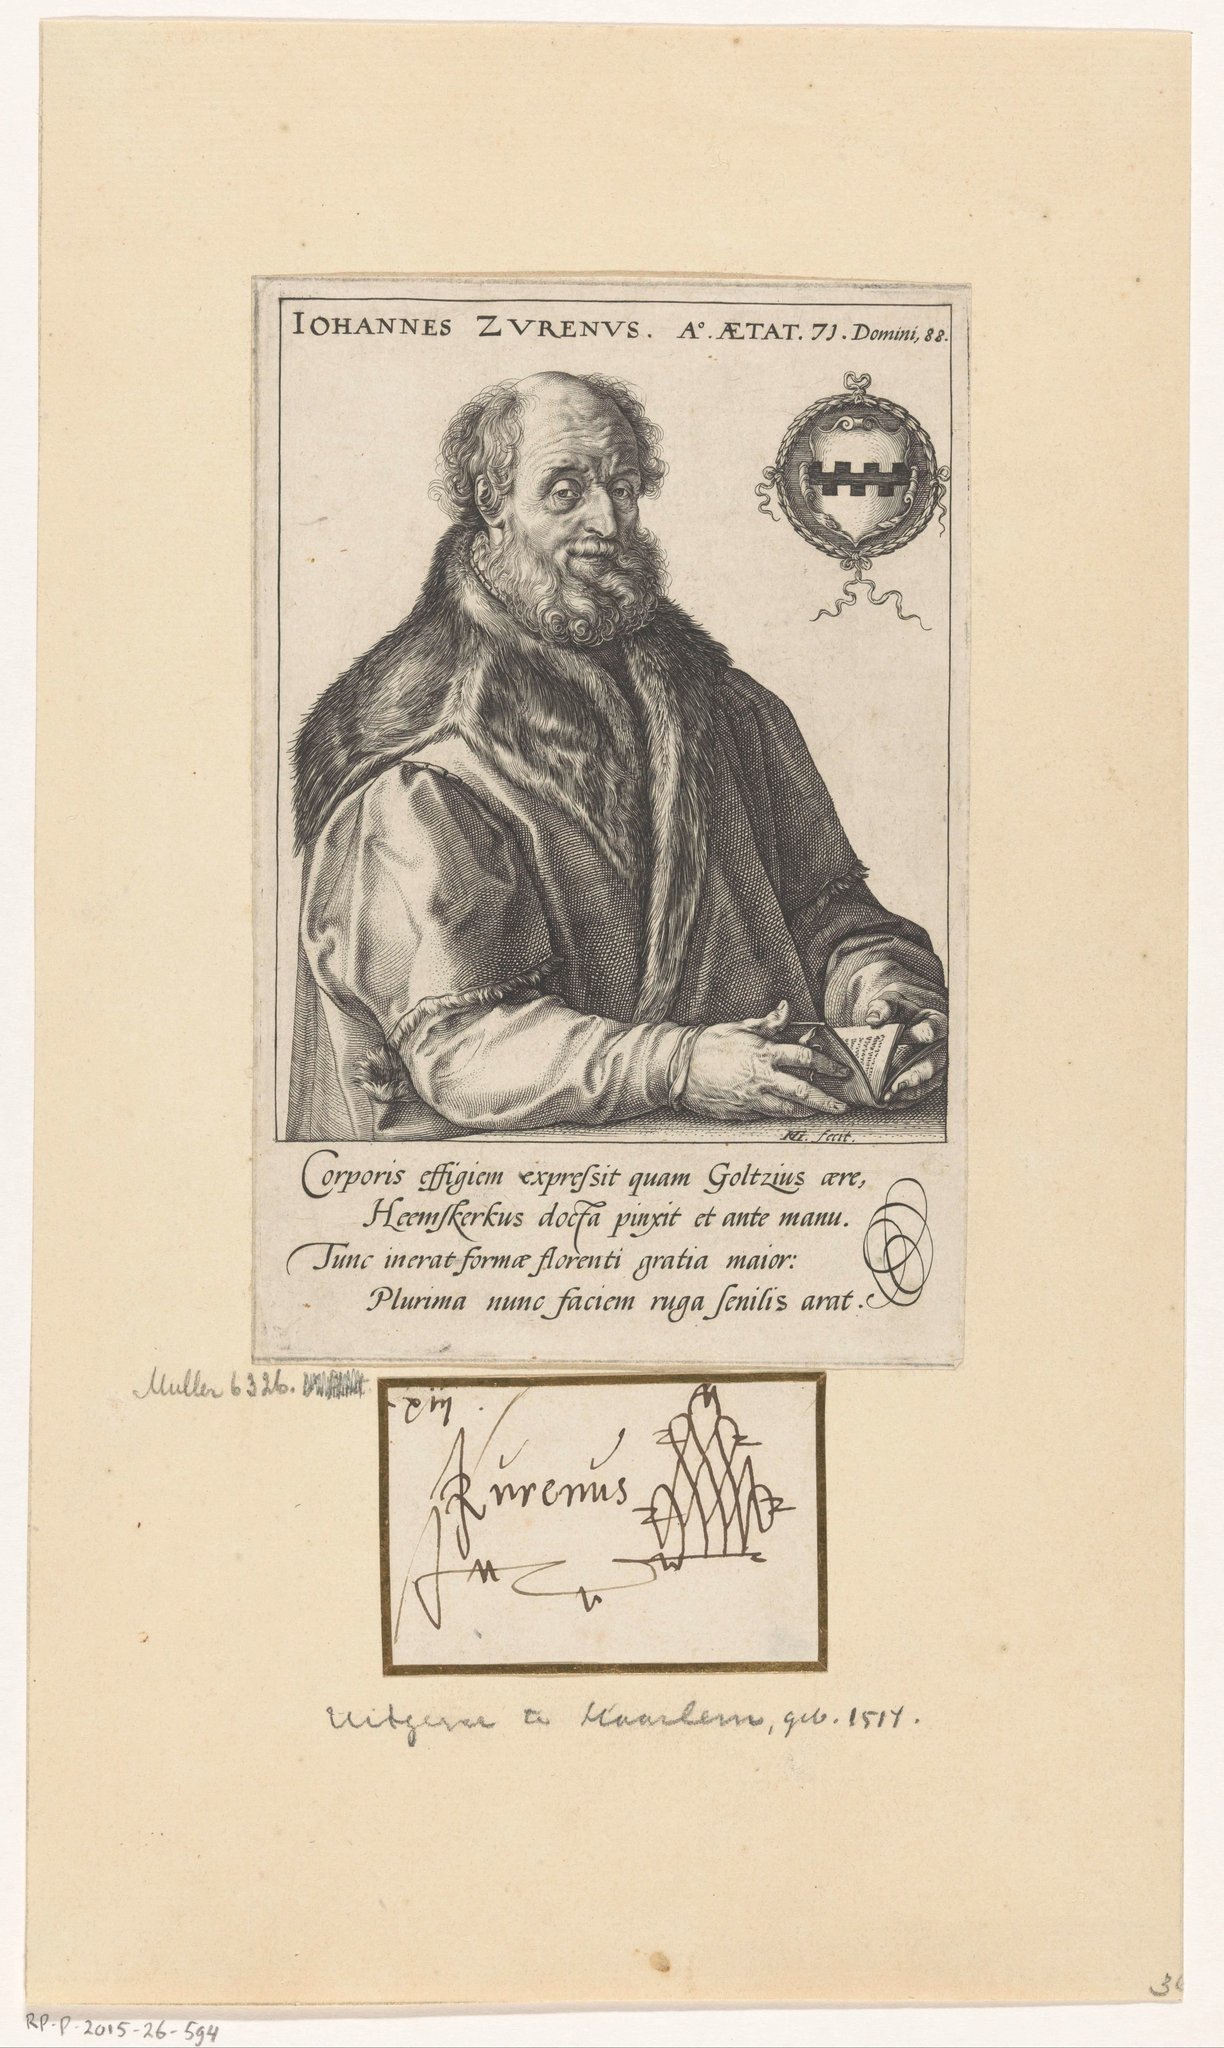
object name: print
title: Portret van Johan van Zuren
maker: hendrick goltzius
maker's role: draughtsman, painter, print maker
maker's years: 1558-1617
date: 1588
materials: paper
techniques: engraving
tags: mayor, book, publishing, publisher, printer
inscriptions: collector's mark: Lugt 4780, collector's mark: Lugt 2228, collector's mark: Lugt 1120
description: Portret van de drukker/uitgever en burgemeester van Haarlem Jan van Suren (1517-1591). Van Suren is hier 71 jaar oud. Ten halven lijve afgebeeld achter een tafel, min of meer op de rechterzijde gezien, de blik naar de beschouwer. In zijn handen een boekje. Hij is gekleed in een mantel afgezet met bont. Rechtsboven zijn wapen. Vier regels onderschrift in Latijn.